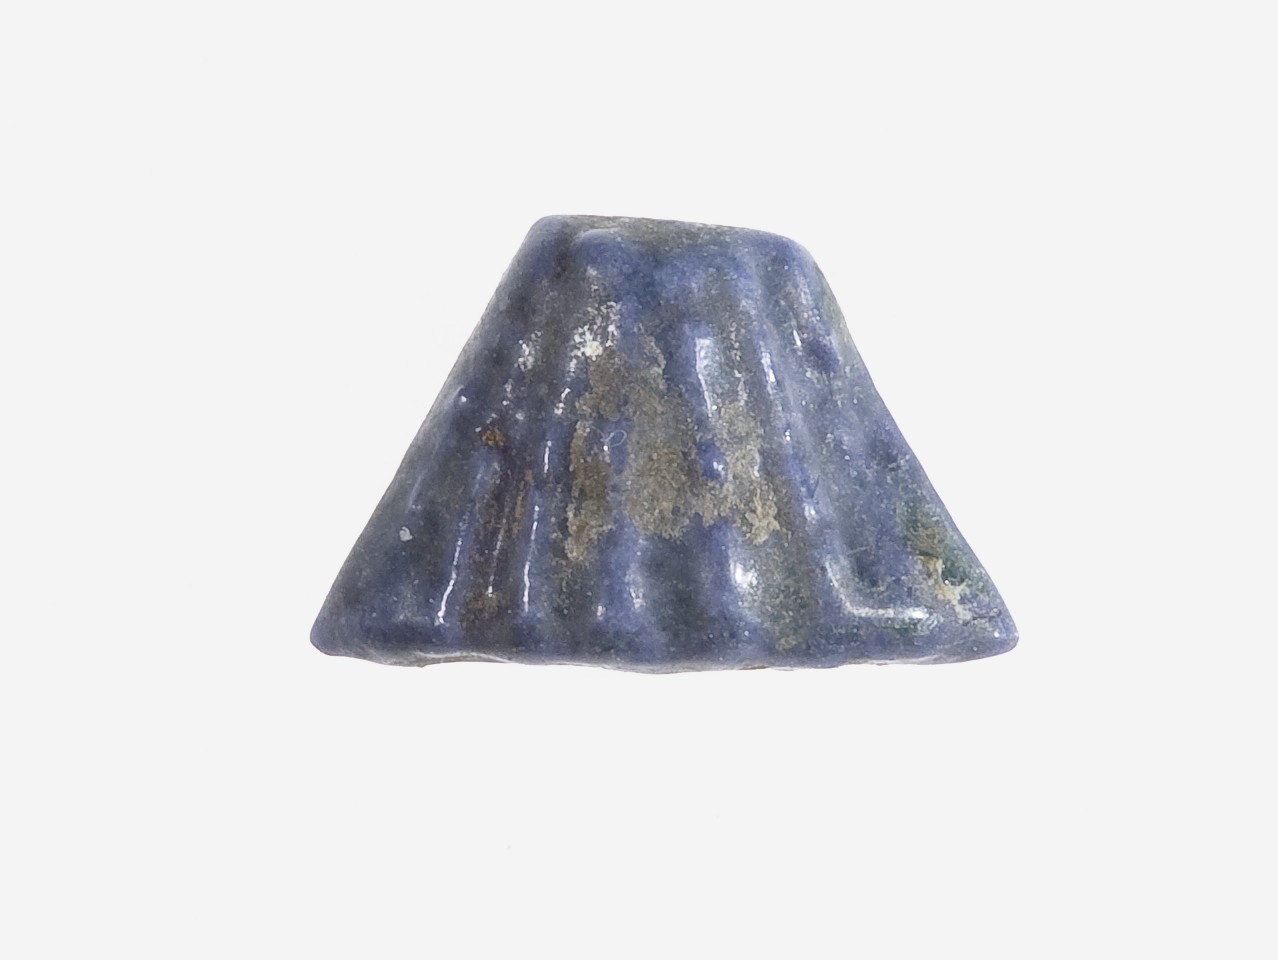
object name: pendant, cornflower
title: Fragments of Cornflower Pendant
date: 1390-1352 BCE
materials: faience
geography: egypt